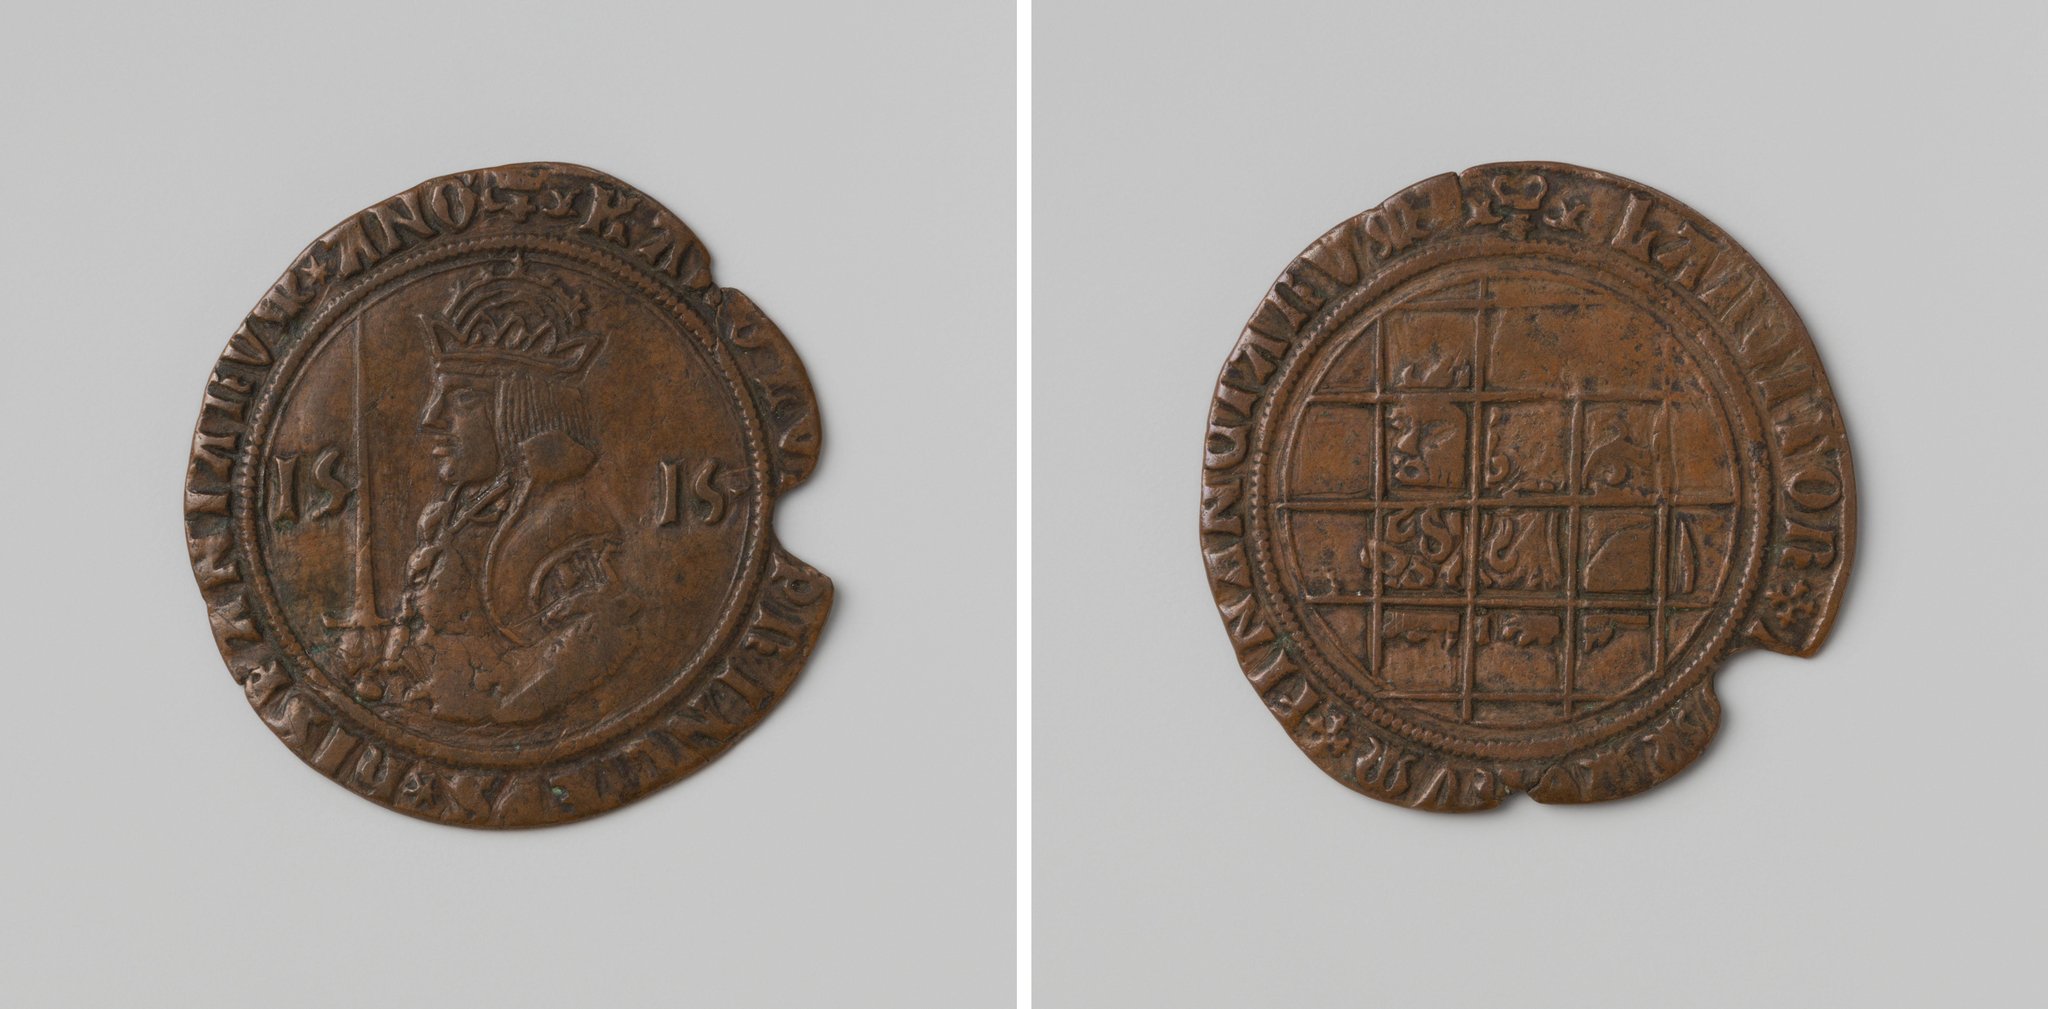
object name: jeton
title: Inhuldiging van Karel als heer der Nederlanden, rekenpenning van de hofmeester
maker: Anonymous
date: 1515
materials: copper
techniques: striking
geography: netherlands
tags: charles v (holy roman emperor and king of spain), netherlands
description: Koperen penning. Voorzijde: gekroonde aartshertog Karel, met getrokken zwaard in rechterhand tussen jaartal binnen omschrift. Keerzijde: liggende leeuw achter beschuttend hek binnen omschrift